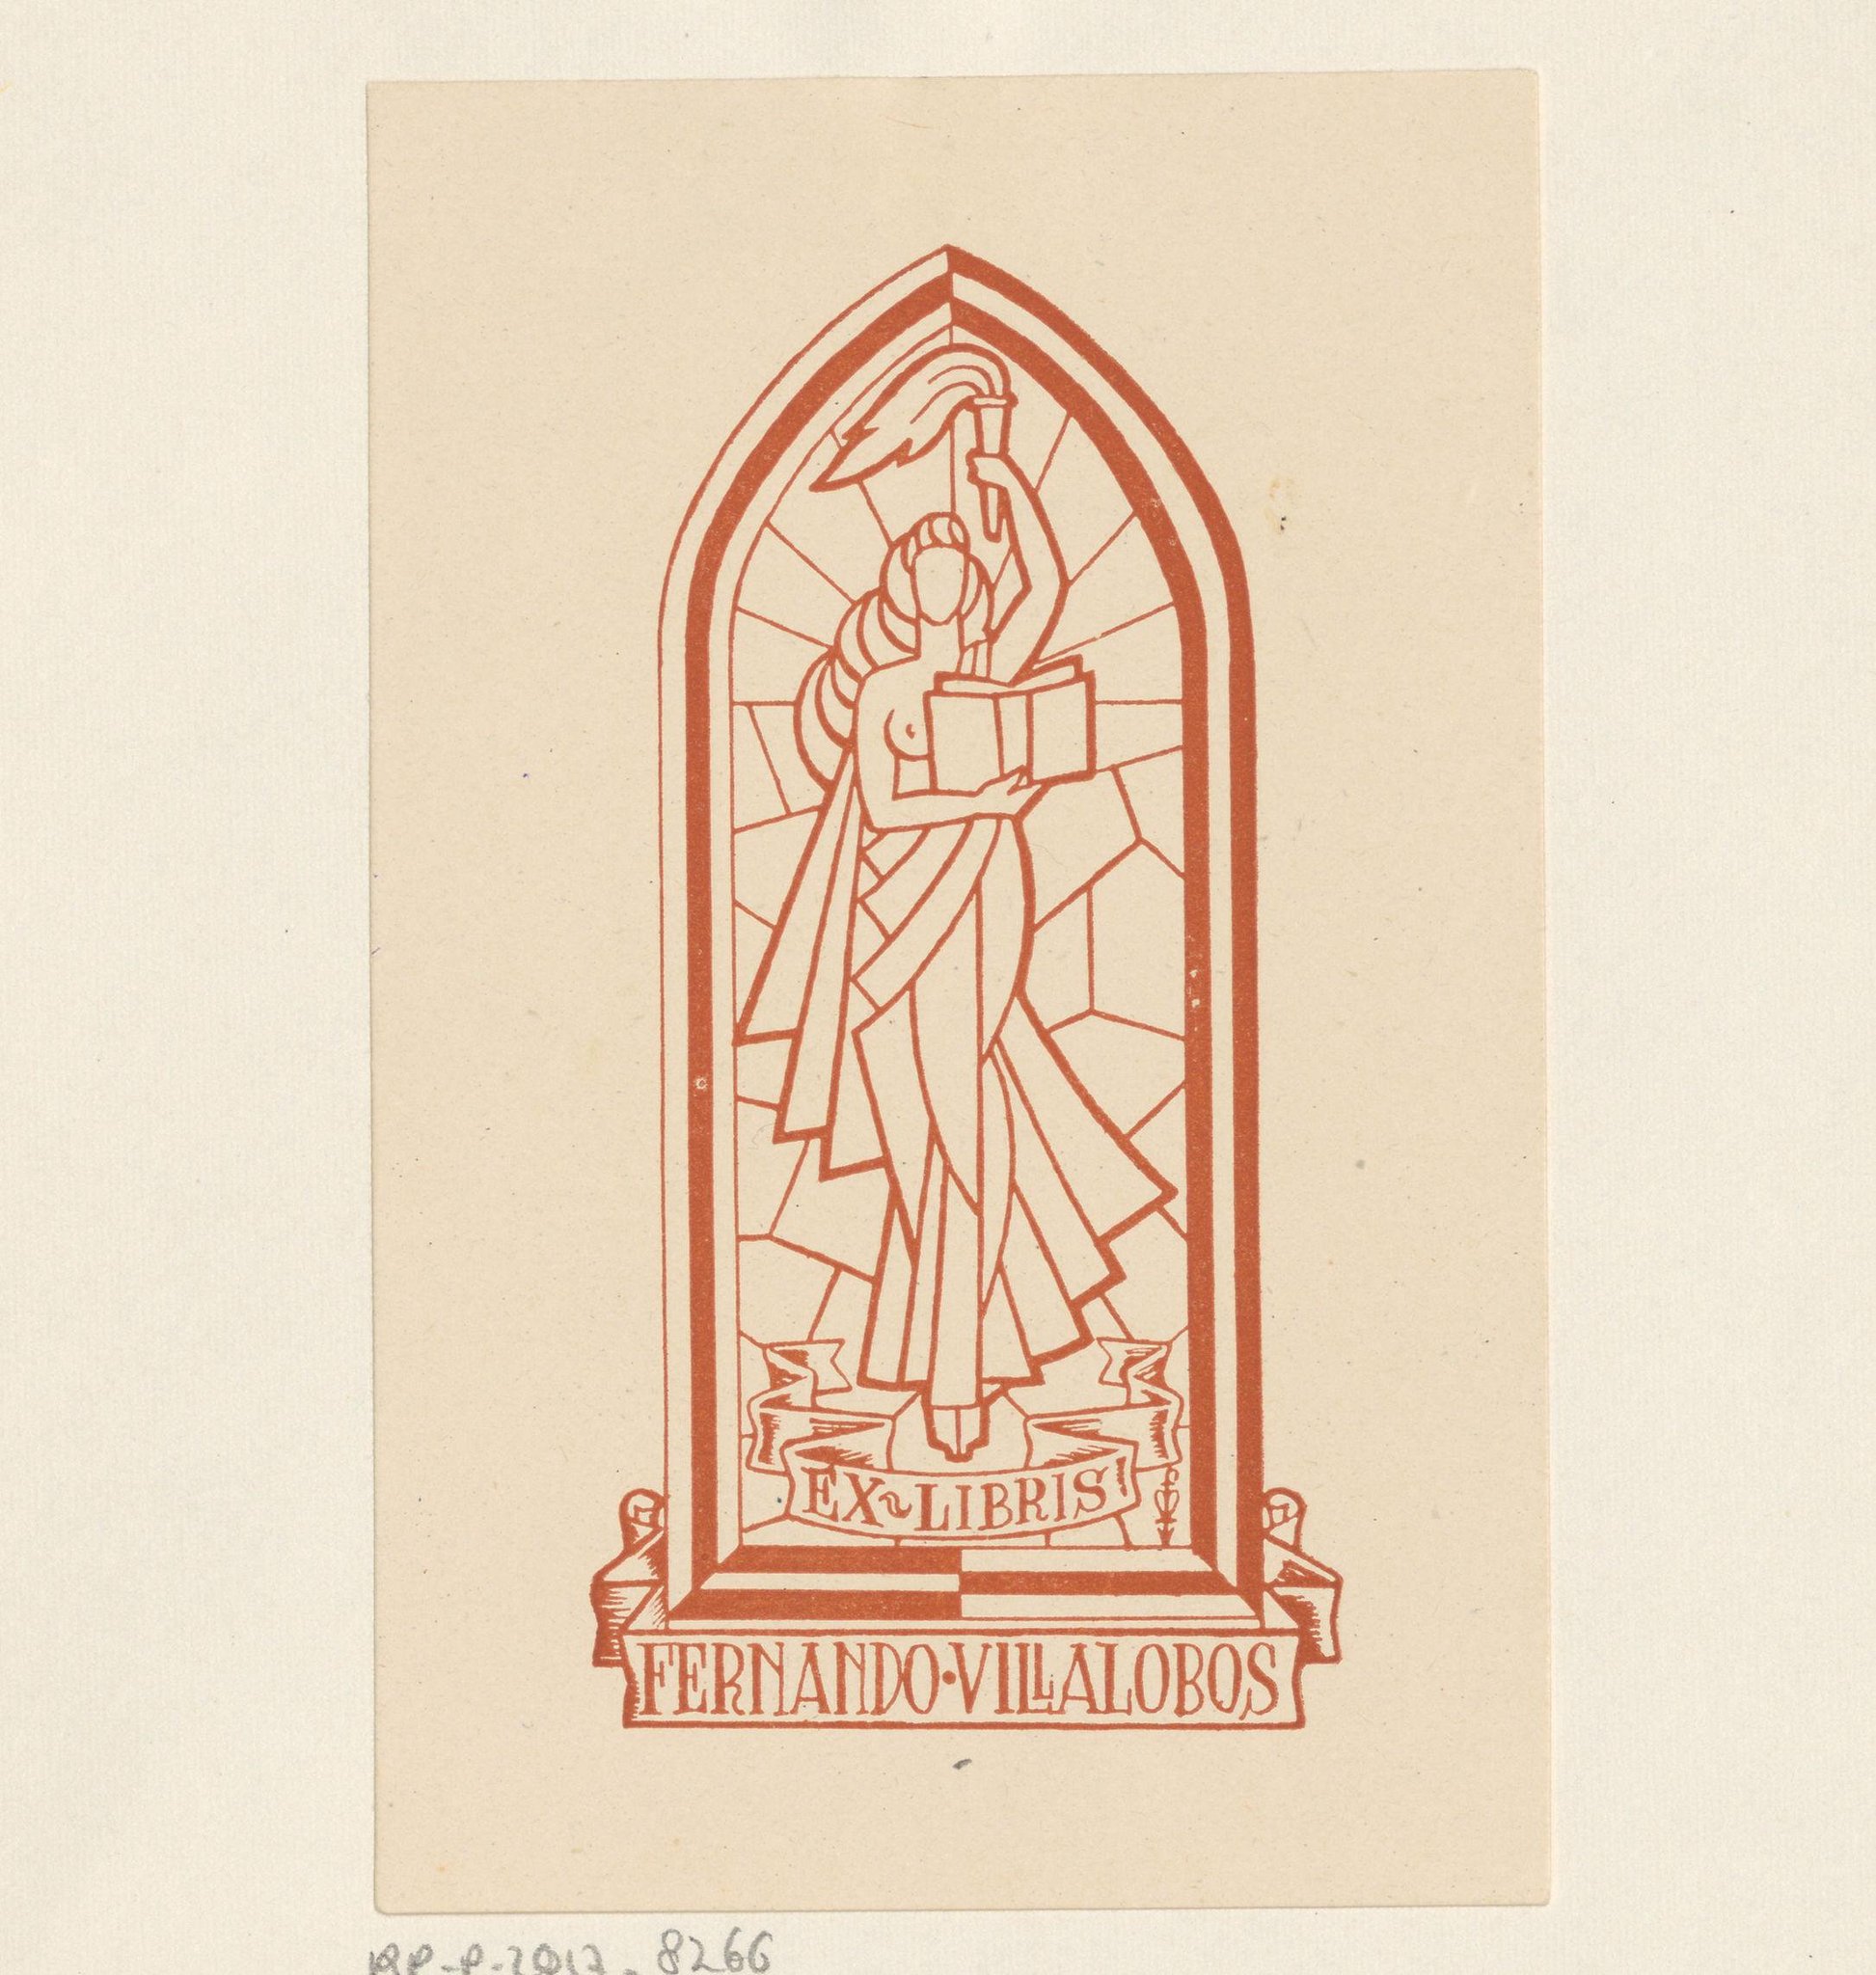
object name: bookplate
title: Ex libris van Fernando Villalobos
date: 1948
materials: paper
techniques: printing block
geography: spain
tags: fernando villalobos, torch, church-window, e.g. rose-window, woman (showing herself) undressed, quasi-nude, book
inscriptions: workshop stamp: ‘1948/ Ipse fecit/ España’